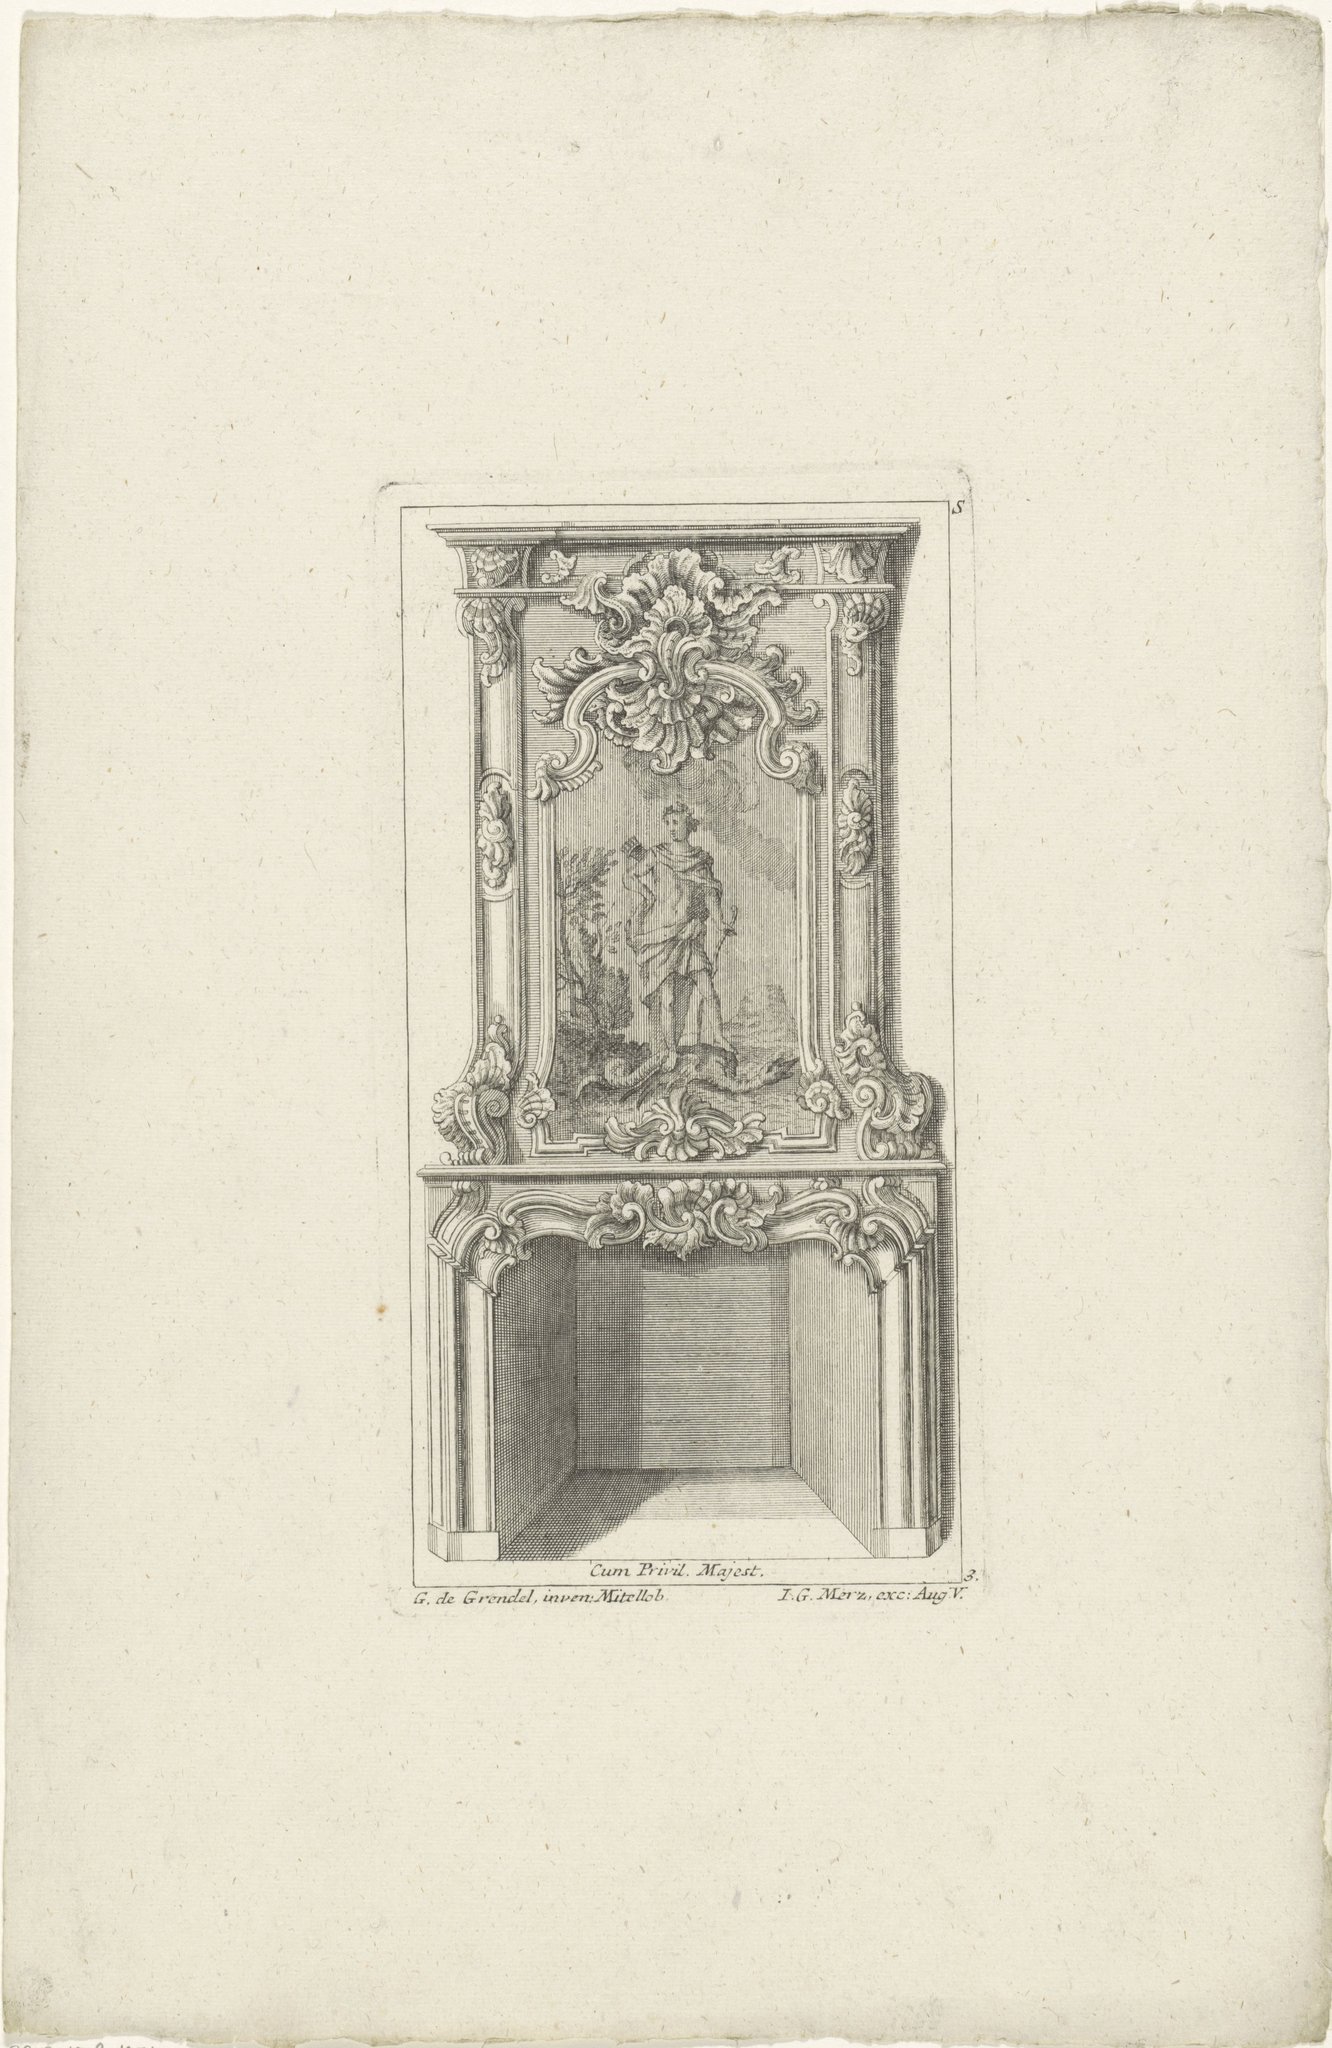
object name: ornament print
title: Neu inventirte Hollaendische Camine, Erster Theil / Nouveau Livre de Chéminees Hollandoises Premiere Partie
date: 1709-1762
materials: paper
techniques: engraving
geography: augsburg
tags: chimney, apollo shoots python, the dragon, rocaille ornament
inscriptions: collector's mark: Lugt 2228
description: Ontwerp voor een schoorsteen met een voorstelling van Apollo met pijlen en boog staande op de door hem overwonnen draak Python. De schoorsteenmantel is versierd met rocailleornamenten.